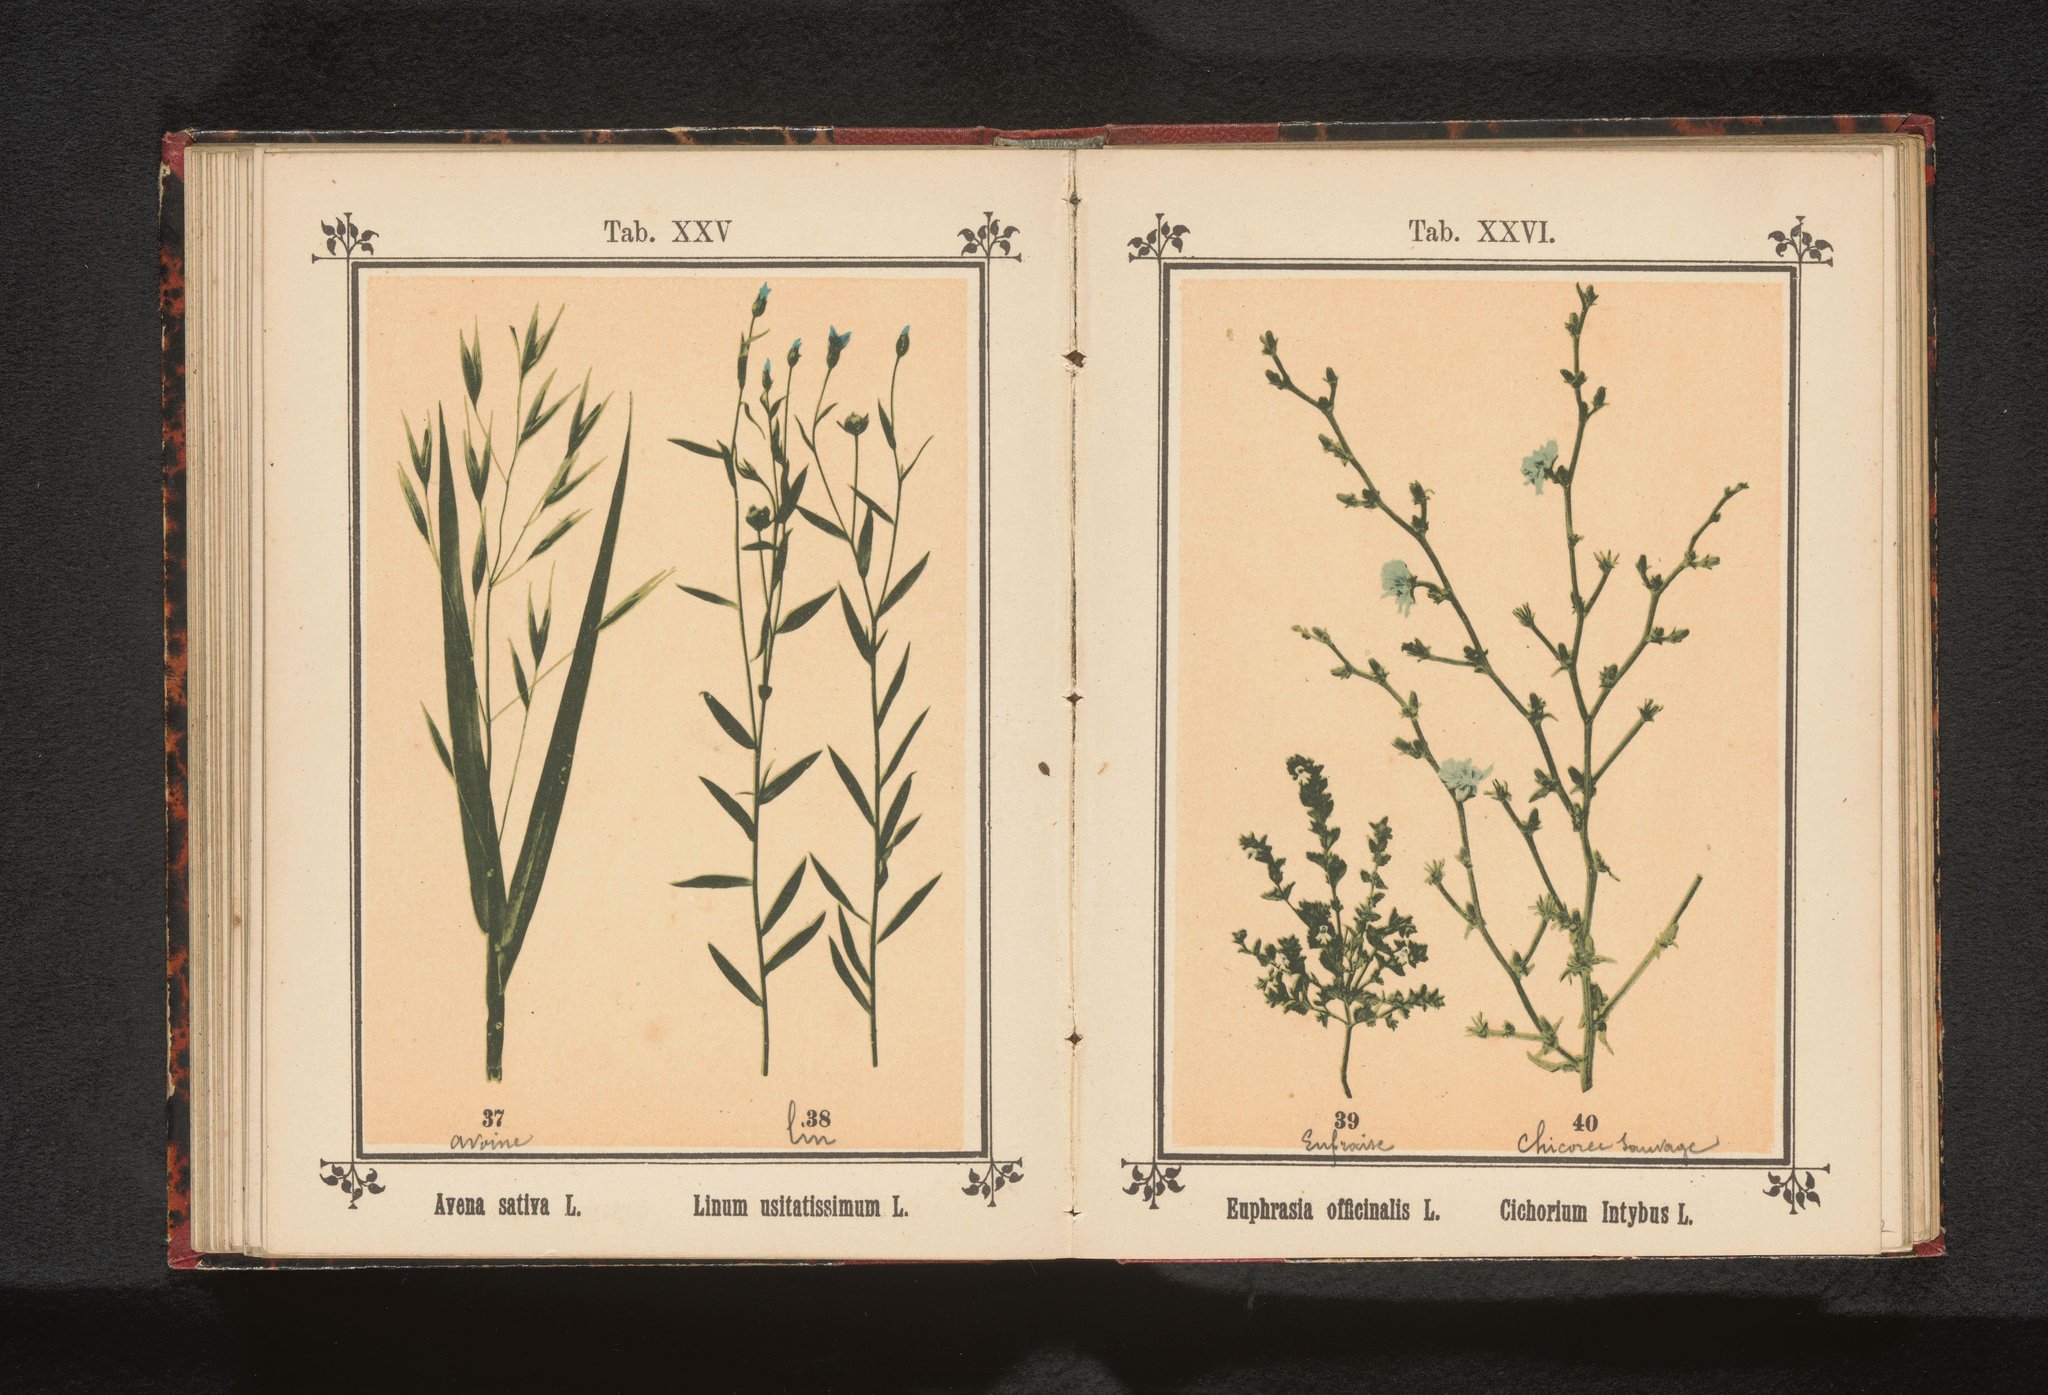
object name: page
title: Ogentroost en wilde cichorei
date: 1884-1894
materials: paper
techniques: photograph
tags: plants and herbs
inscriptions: inscription: ‘Enfraise chicoree sauvage’, number: ‘Tab. XXVI.’